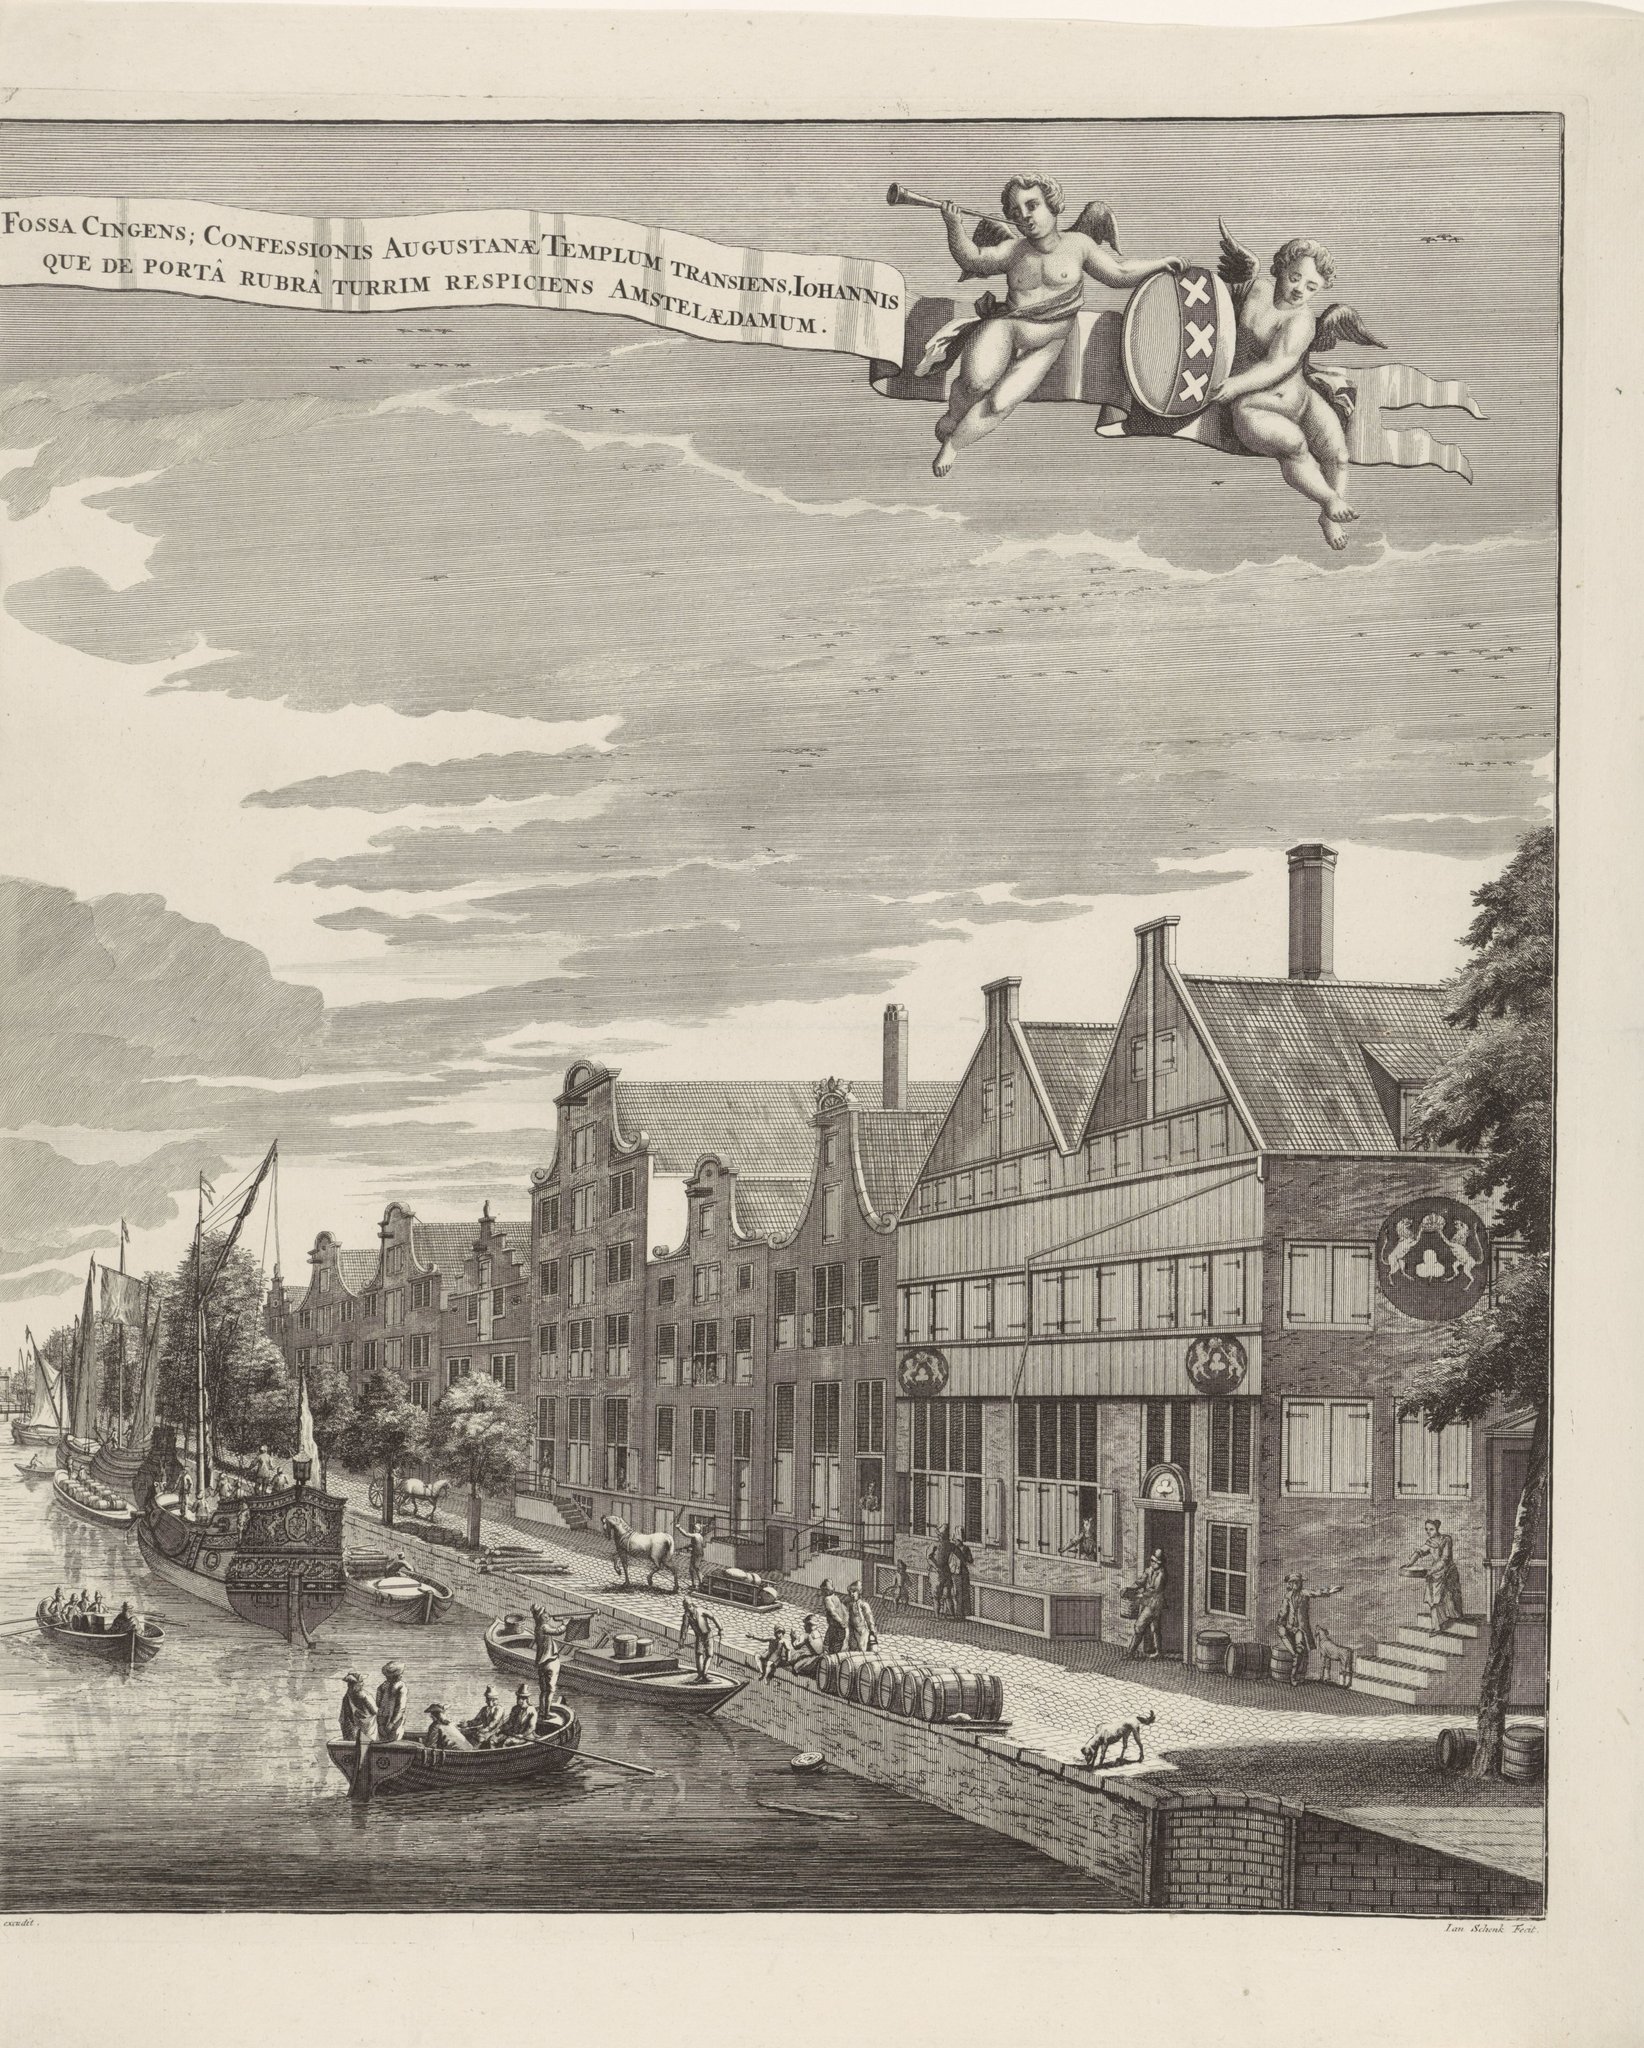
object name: print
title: Singel te Amsterdam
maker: jan schenk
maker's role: draughtsman, print maker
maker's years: 1698-1752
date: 1731-1746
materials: paper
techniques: etching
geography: amsterdam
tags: sailing-ship, sailing-boat, (bowling a) hoop, dog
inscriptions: collector's mark: Lugt 2228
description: Gezicht op een gedeelte van het Singel te Amsterdam. Aan de kade van de gracht liggen verschillende schuiten. Op de kant zijn mensen te zien, waaronder een man met een paard en een kind met een hoepel. In de lucht een banderol met tekst en twee putto met het wapen van Amsterdam.